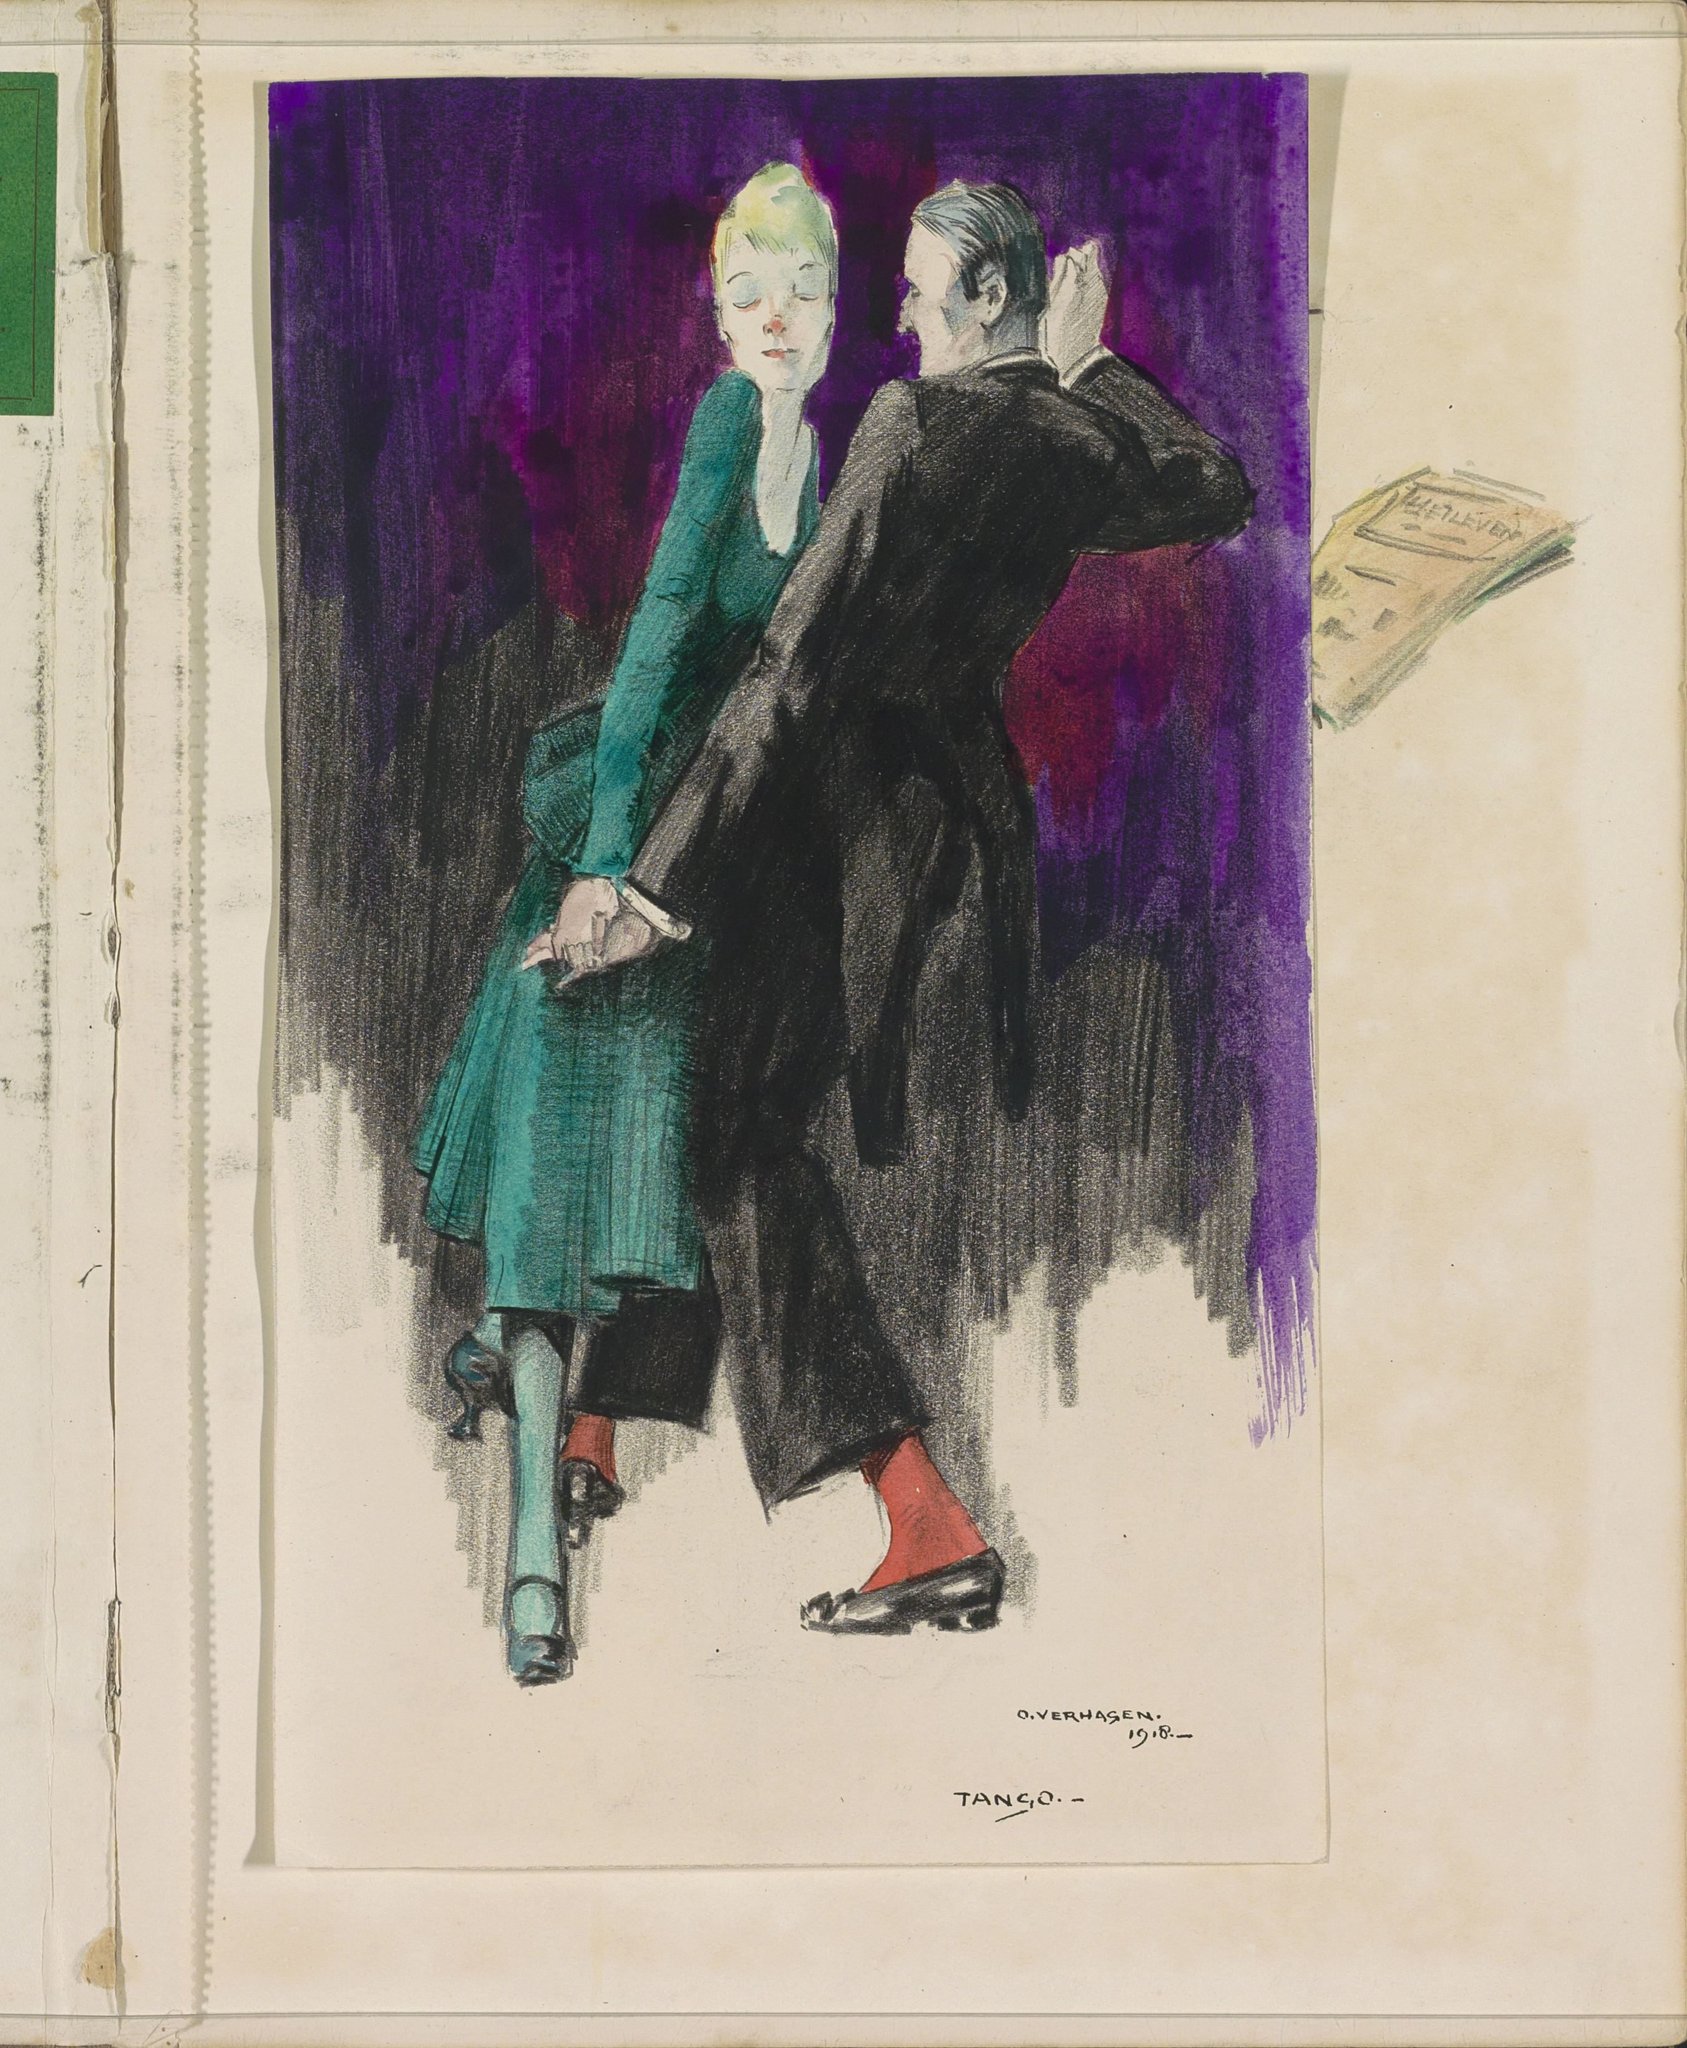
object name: sketchbook leaf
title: Tango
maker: otto verhagen (i)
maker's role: draughtsman, print maker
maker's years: 1885-1951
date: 1917-1919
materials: chalk, ink, paper, pencil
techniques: brush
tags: one pair dancing; man and woman dancing as a couple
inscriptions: signature: ‘O. VERHAGEN./ 1918.-’, annotation: ‘TANGO.-’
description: Losse tekening tussen het voorste schutblad en pagina 1 uit een schetsboek met 28 bladen.